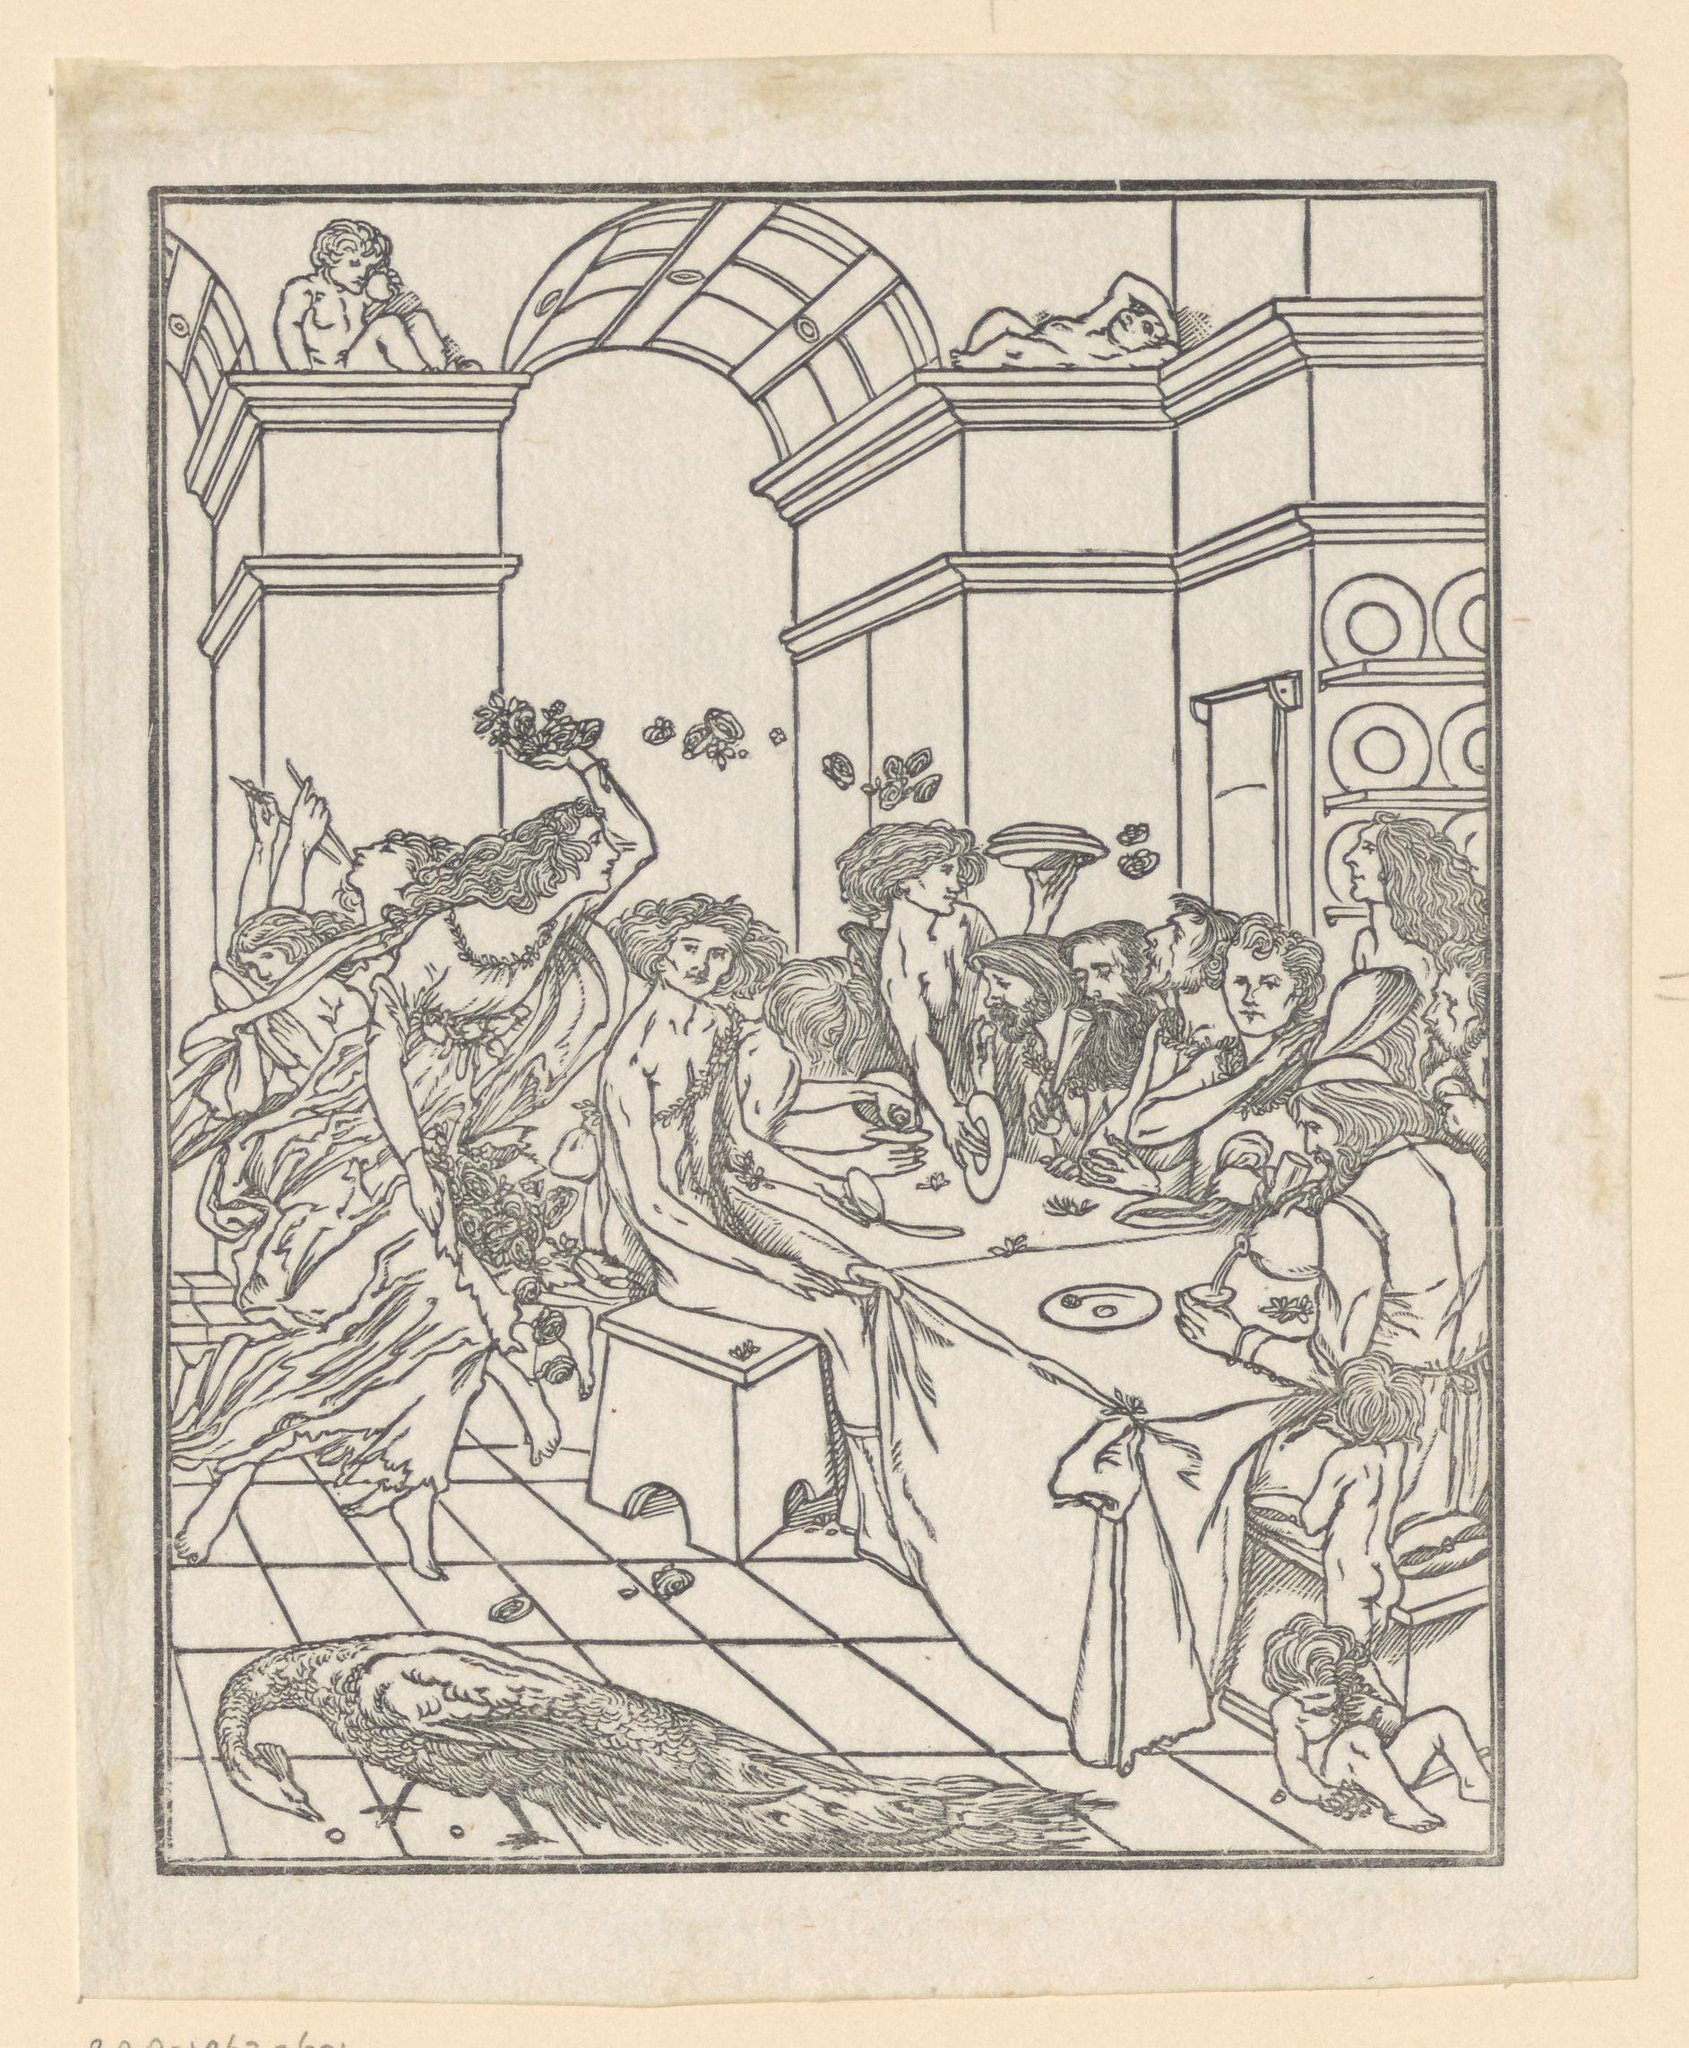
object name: print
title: Bruiloft van Daphnis en Chloe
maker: charles ricketts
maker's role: print maker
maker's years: 1866-1931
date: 1893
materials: paper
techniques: woodcut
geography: london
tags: wedding feast, wedding meal, ornamental birds: peacock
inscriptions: inscription: ‘Ch. Ricketts, the wedding feast; Original woodcut for "Daphnis & Chloe" trial proof’, collector's mark: Lugt 2228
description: Proefdruk voor een prent uit: Longus. Daphnis and Chloe. Londen: The Vale Press, 1893. Mogelijk gaat het om een proefdruk.